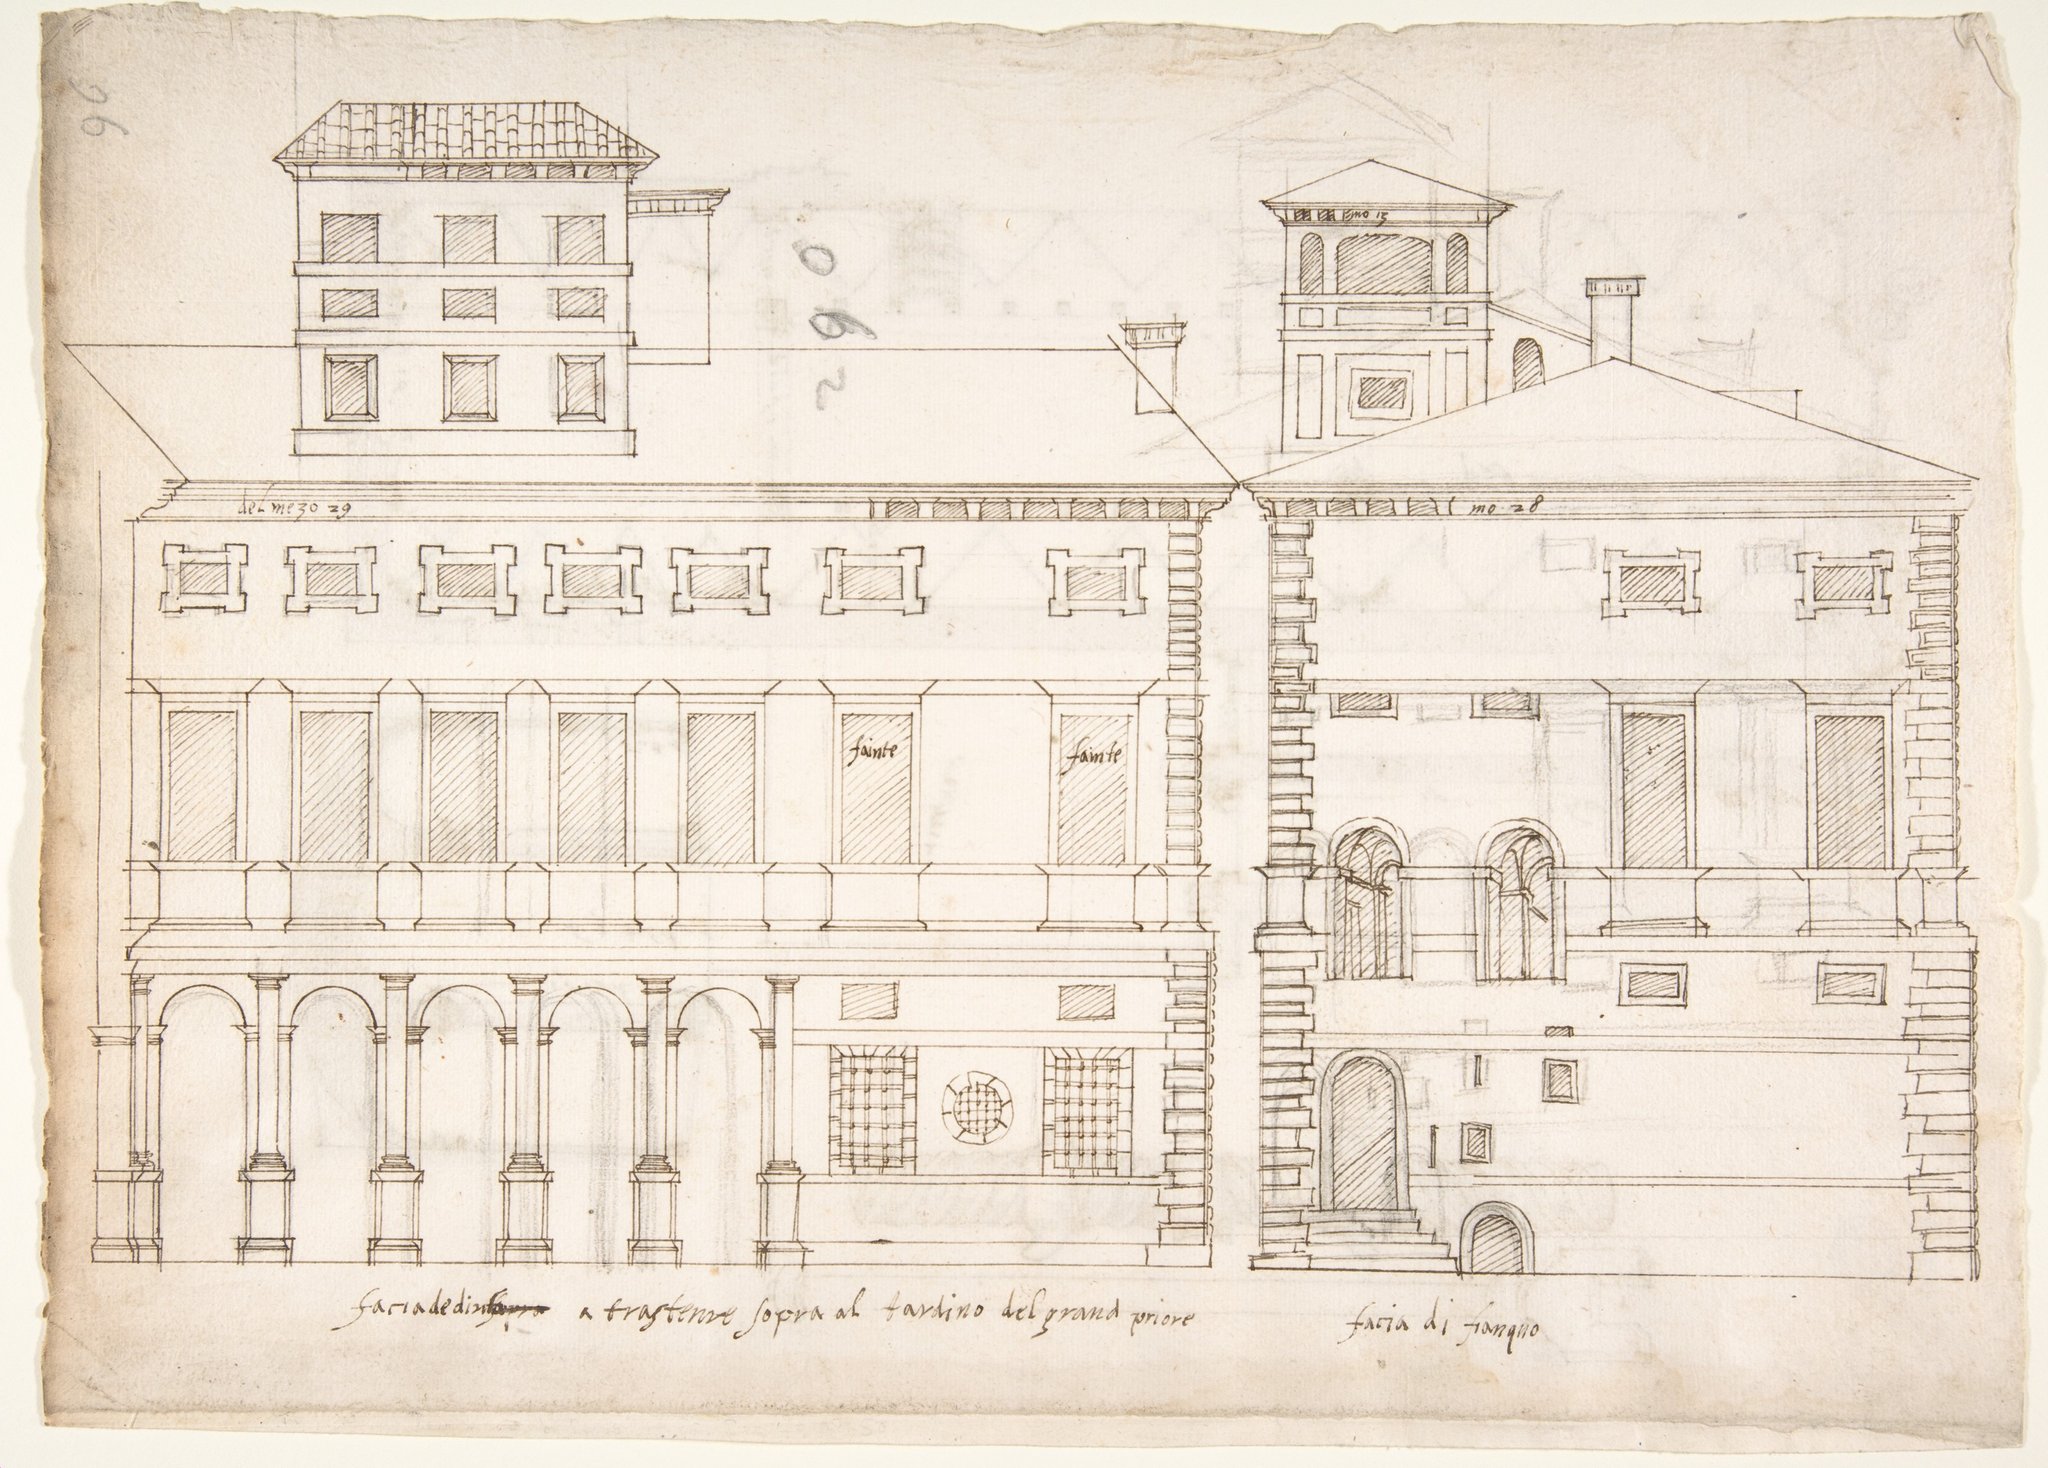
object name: drawing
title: Palazzo Salviati-Adimari elevations (recto) Villa Farnesina stables, plan and section; drawing of a screw (verso)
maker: anonymous, french, 16th century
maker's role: draftsman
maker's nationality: french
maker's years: 1500-1600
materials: chalk, ink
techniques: incising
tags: architecture,buildings